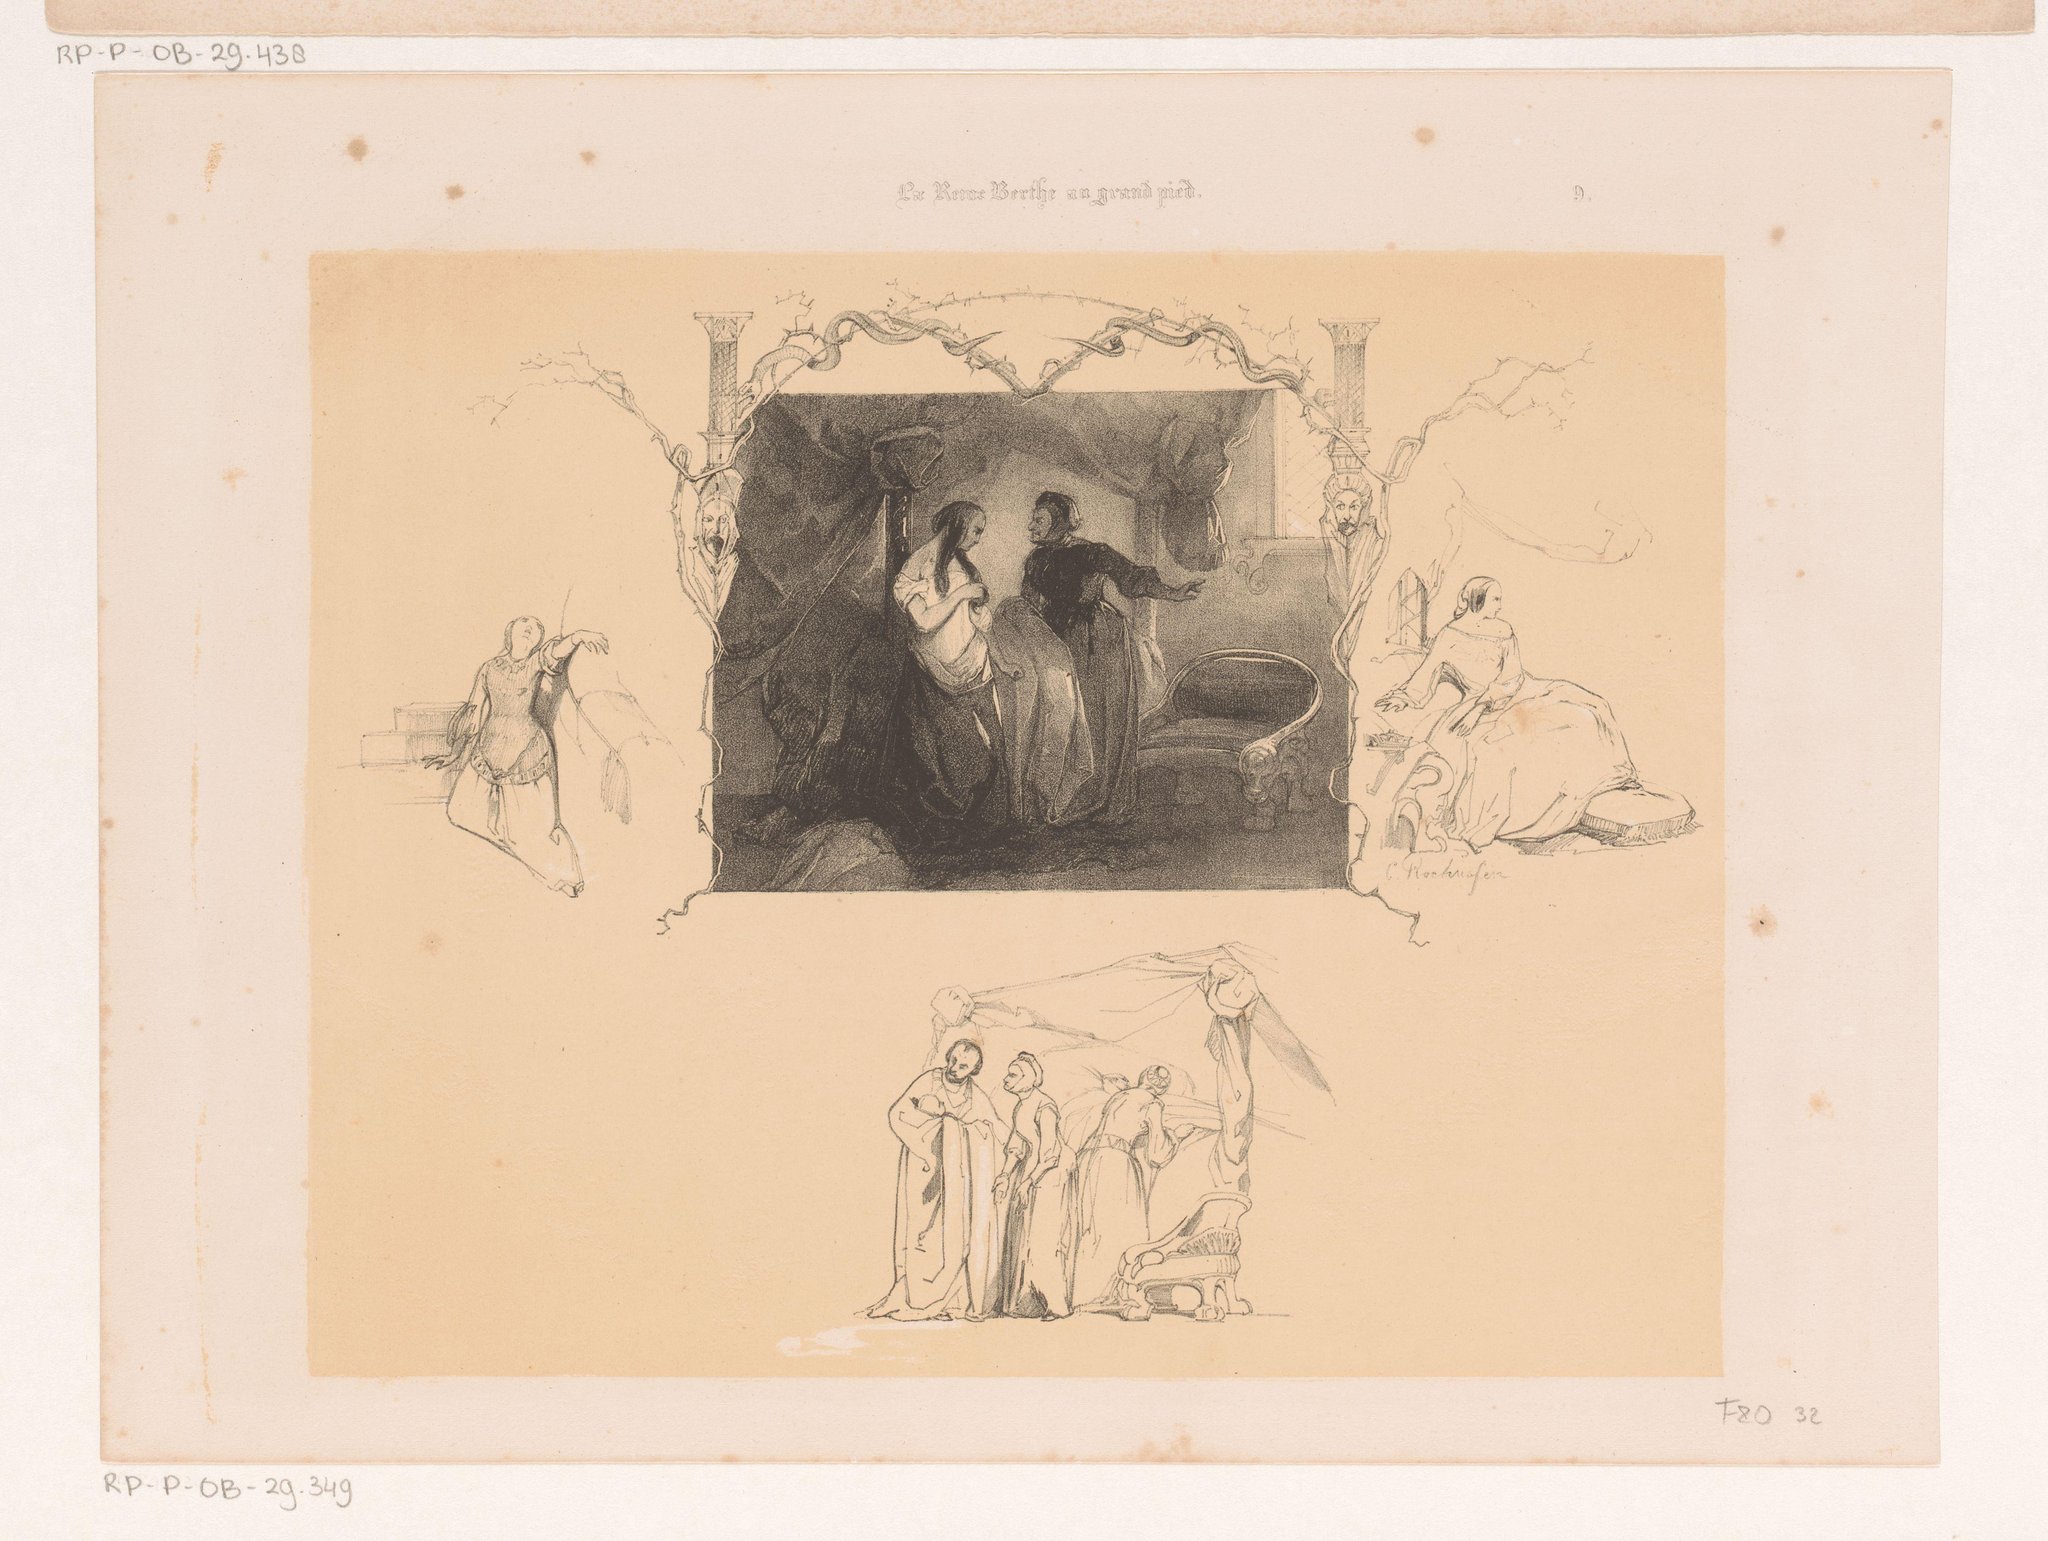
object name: print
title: Jonge en oude vrouw in interieur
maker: charles rochussen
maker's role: draughtsman, painter, print maker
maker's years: 1814-1894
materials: paper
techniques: tone lithography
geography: the hague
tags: conversation, dialogue; conversation piece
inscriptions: collector's mark: Lugt 2228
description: Een jonge en oude vrouw in gesprek, de oude vrouw wijst naar rechts. Rondom diverse scènes met een vrouw en de geboorte van een baby.